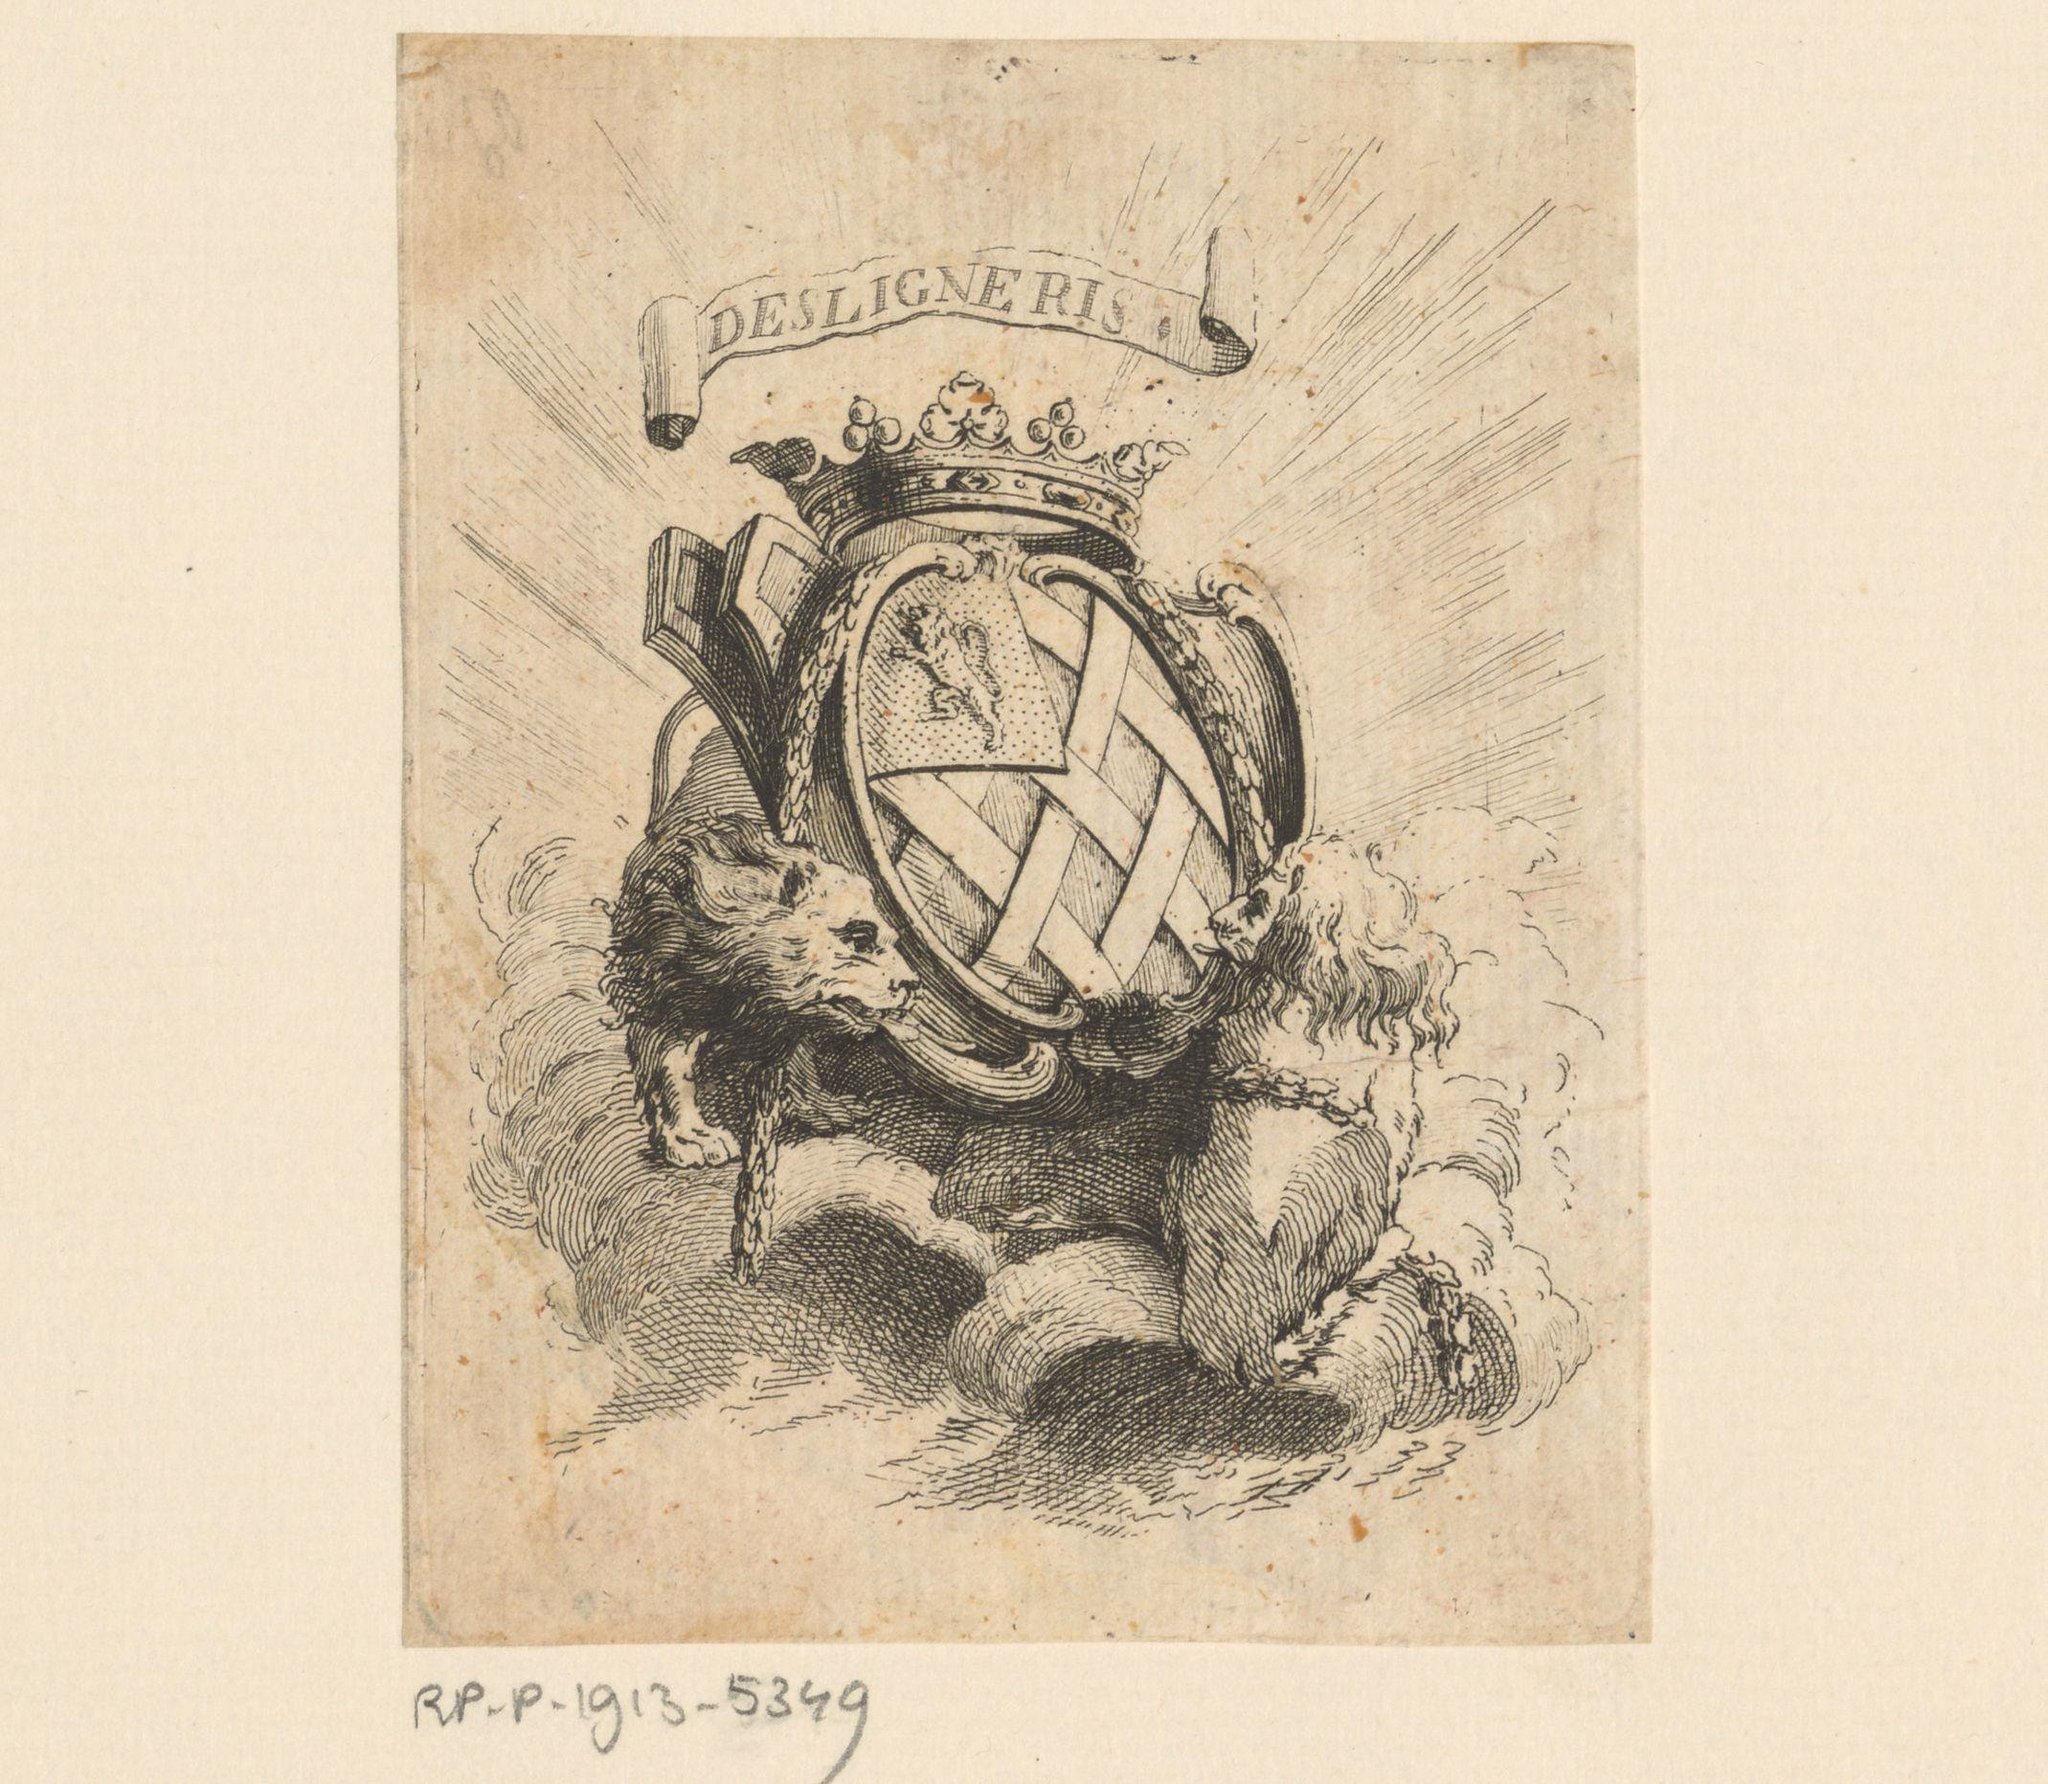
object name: bookplate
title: Ex libris van Des Ligneris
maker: Anonymous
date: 1750-1899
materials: paper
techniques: engraving, etching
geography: france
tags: beasts of prey, predatory animals: lion, armorial bearing, heraldry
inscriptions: collector's mark: Lugt 2760, collector's mark: Lugt 2233